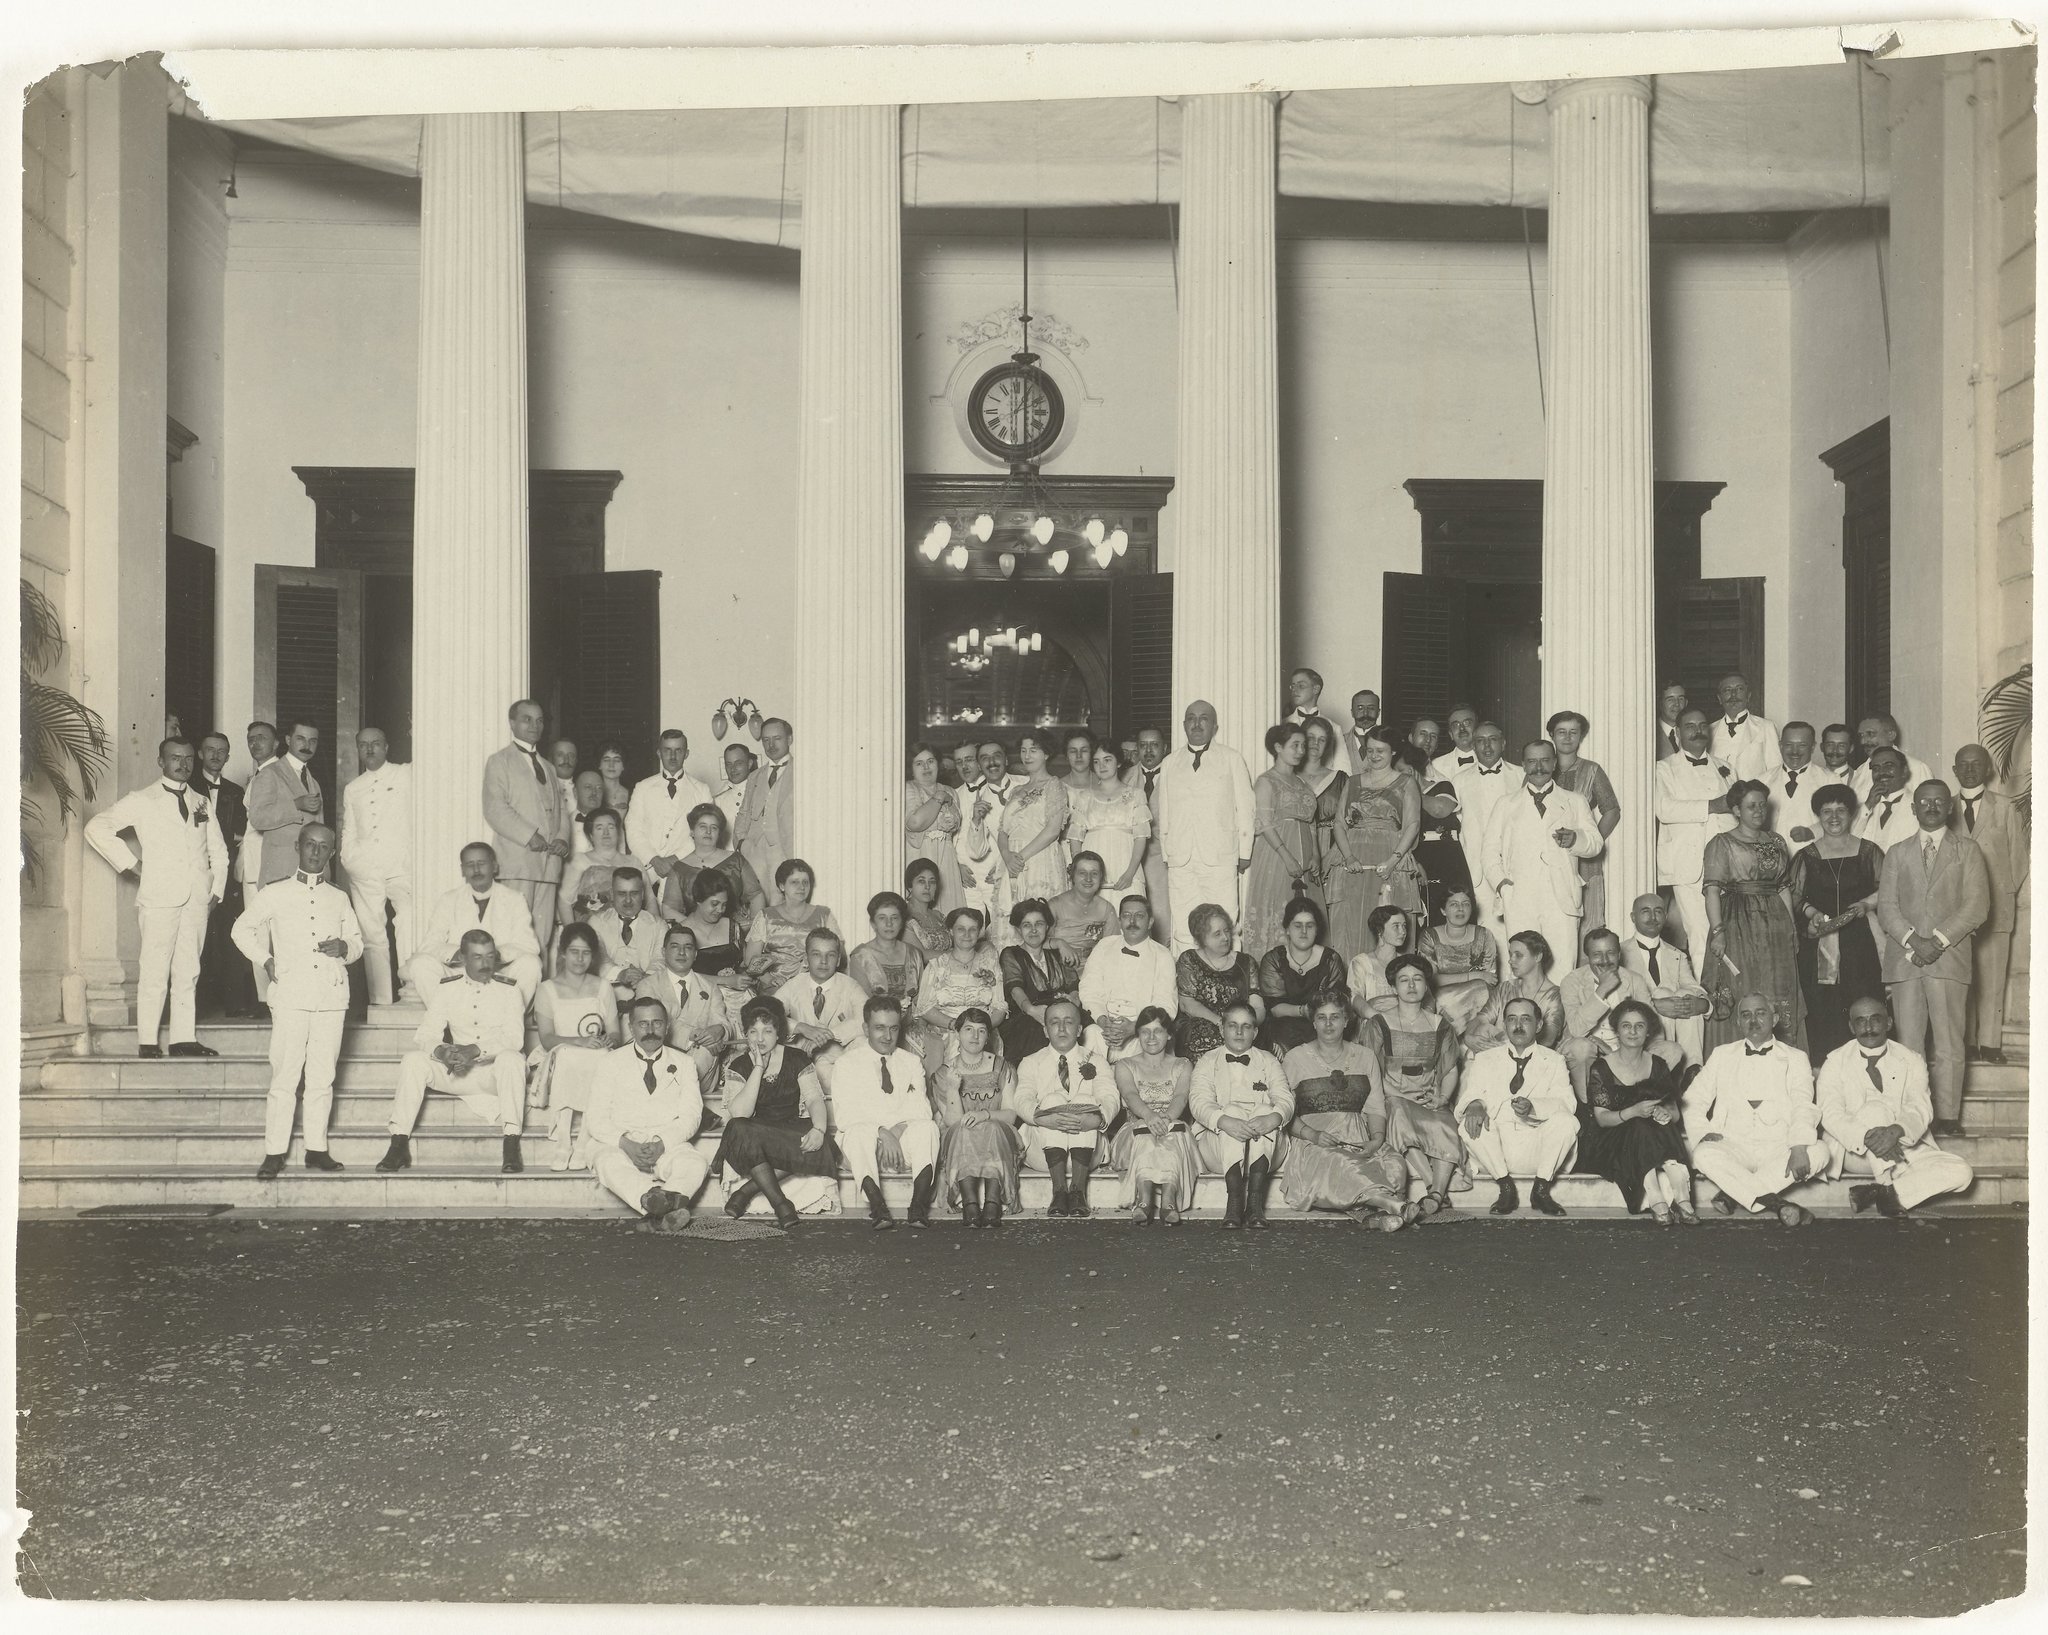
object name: photograph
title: Groepsportret op bordes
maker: Anonymous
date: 1922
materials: photographic support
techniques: photography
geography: dutch east indies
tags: dutch east indies, the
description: Groepsportret op bordes met onder andere het echtpaar Letterie, vermoedelijk naar aanleiding van een feest.